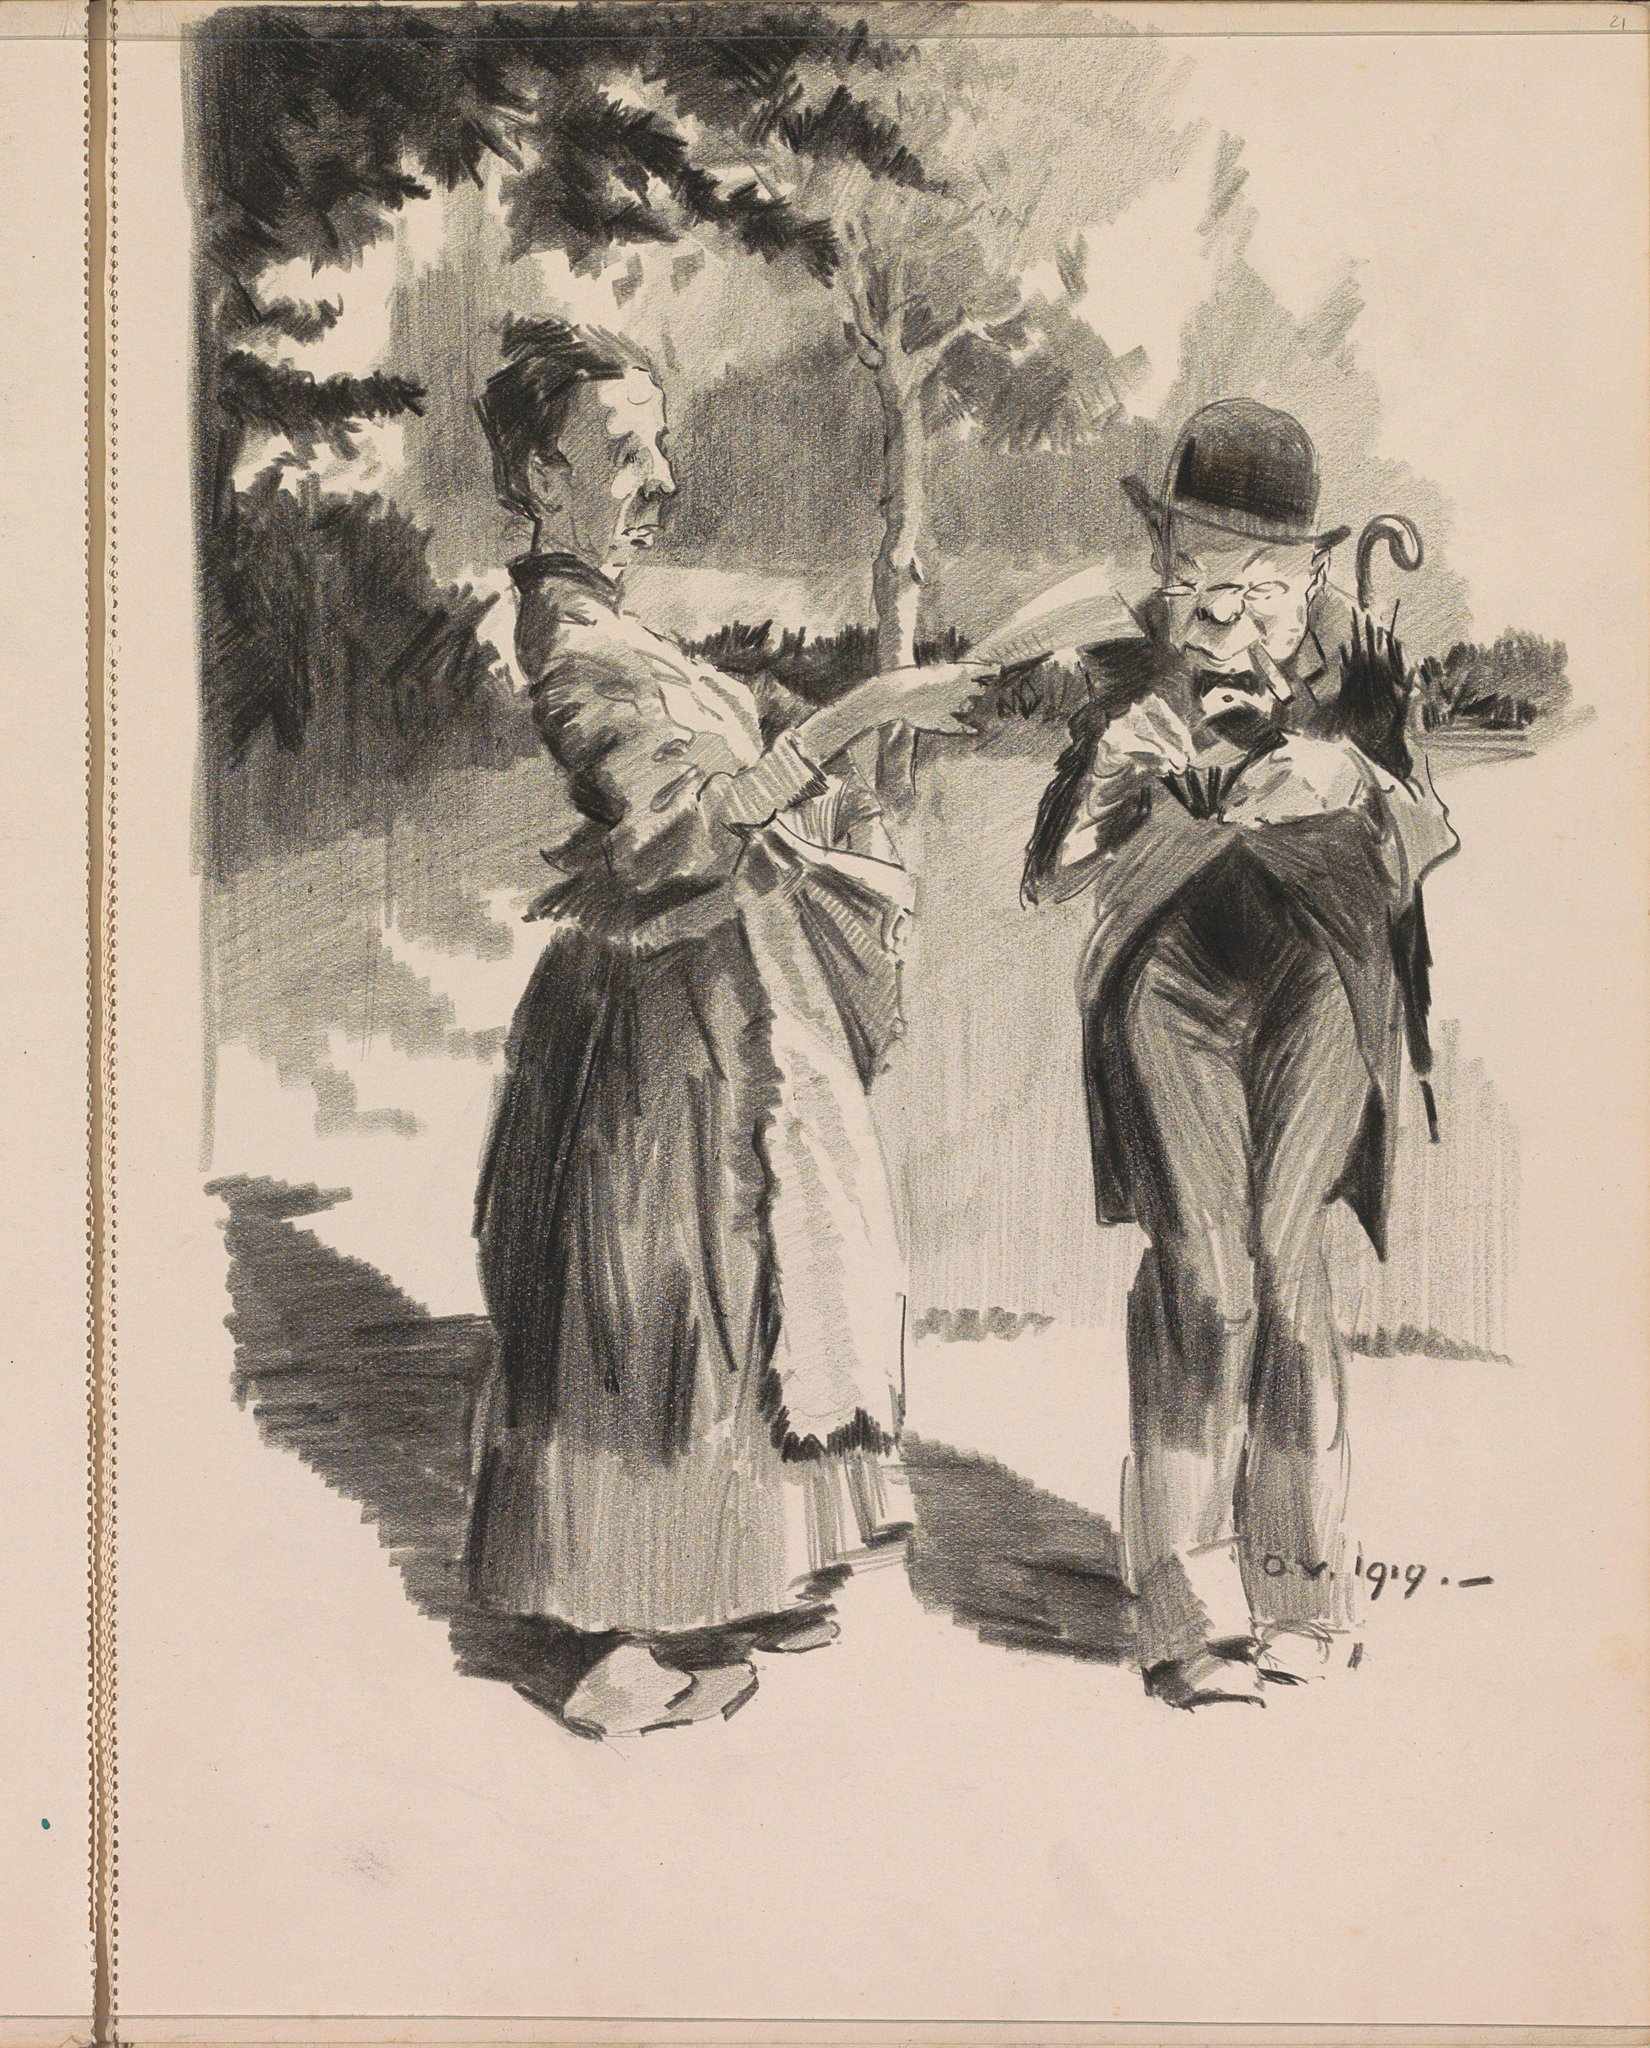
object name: sketchbook leaf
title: Boerin die een document overhandigt aan een man met een bolhoed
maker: otto verhagen (i)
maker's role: draughtsman, print maker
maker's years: 1885-1951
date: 1919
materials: chalk, paper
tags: head-gear: bowler hat, writing tools, farmers - aa - female farmer, farmer's wife, road, path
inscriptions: signature and date: ‘o.v. 1919.-’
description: De twee figuren staan op een pad in een landelijke omgeving. De vrouw steekt het document uit naar de man, die een pak en bolhoed draagt, een paraplu onder de arm heeft geklemd en iets noteert in een opschrijfboekje. Pagina 21 uit een schetsboek met 28 bladen.